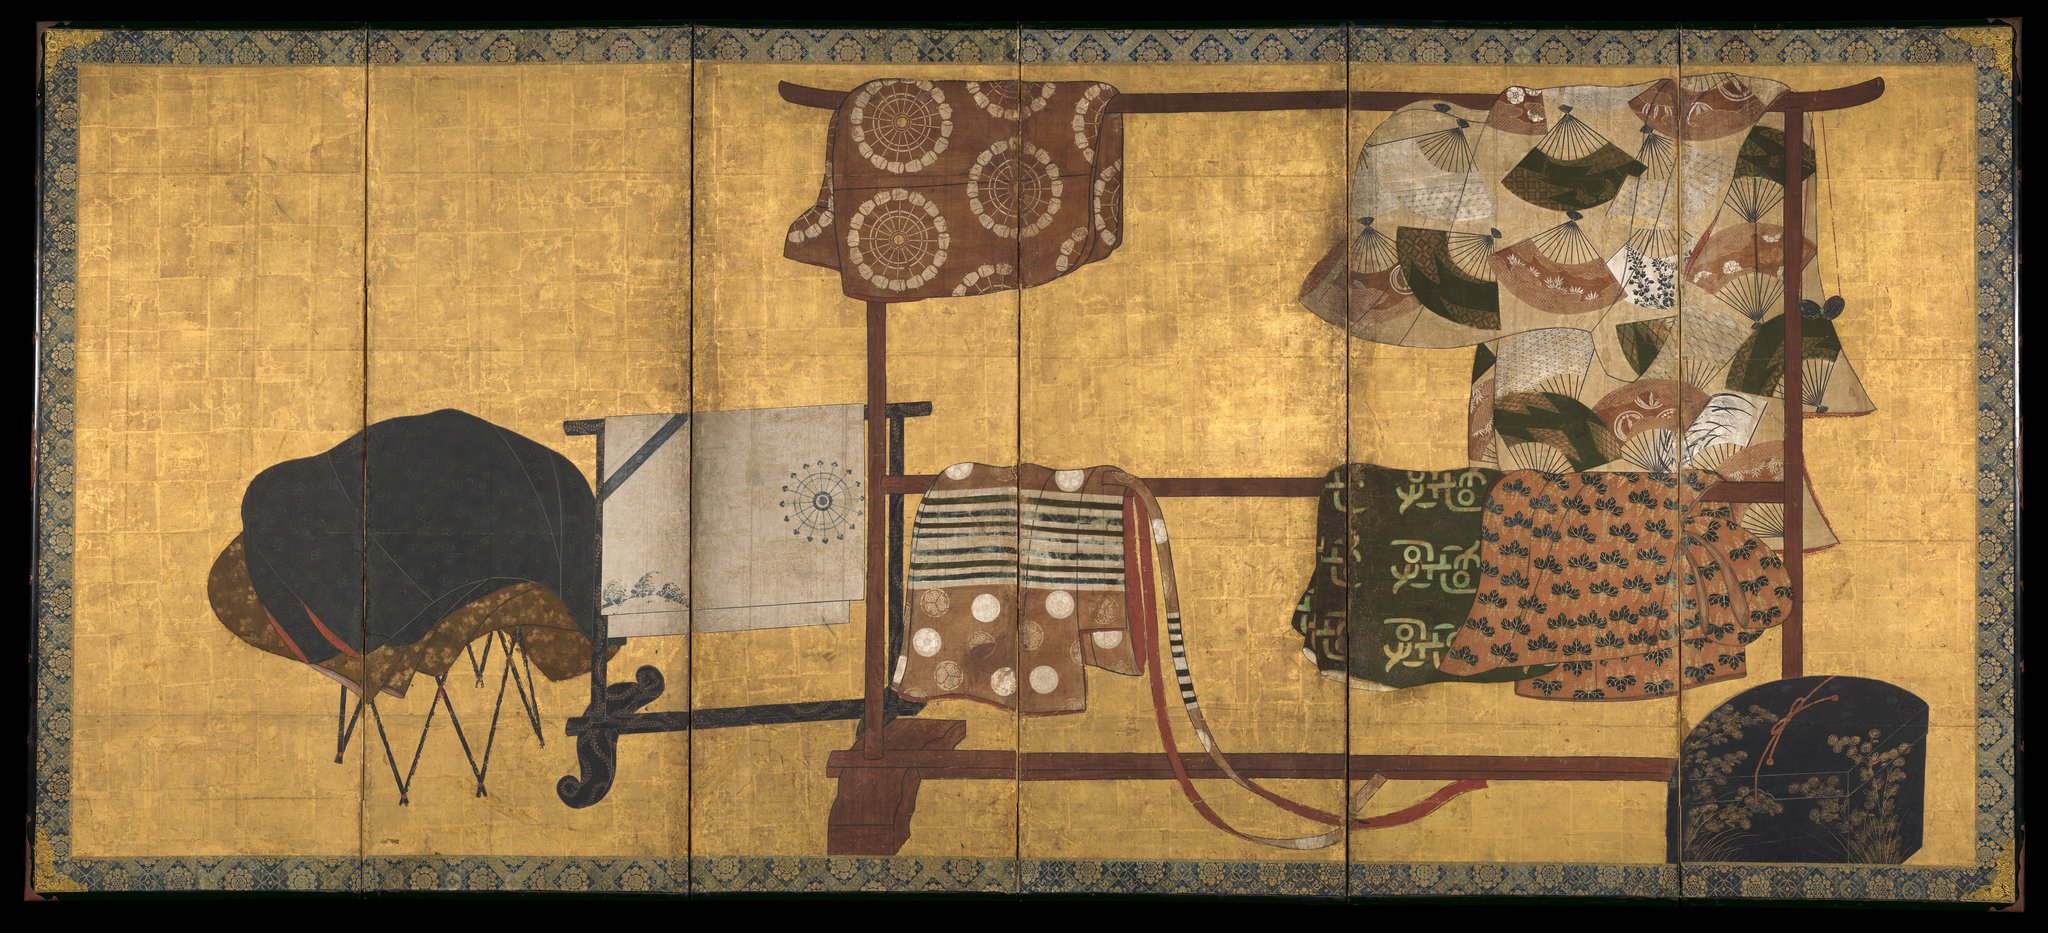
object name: screen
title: Whose Sleeves? (Tagasode)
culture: japanese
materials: gilt, gold, ink, panel, paper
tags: robes